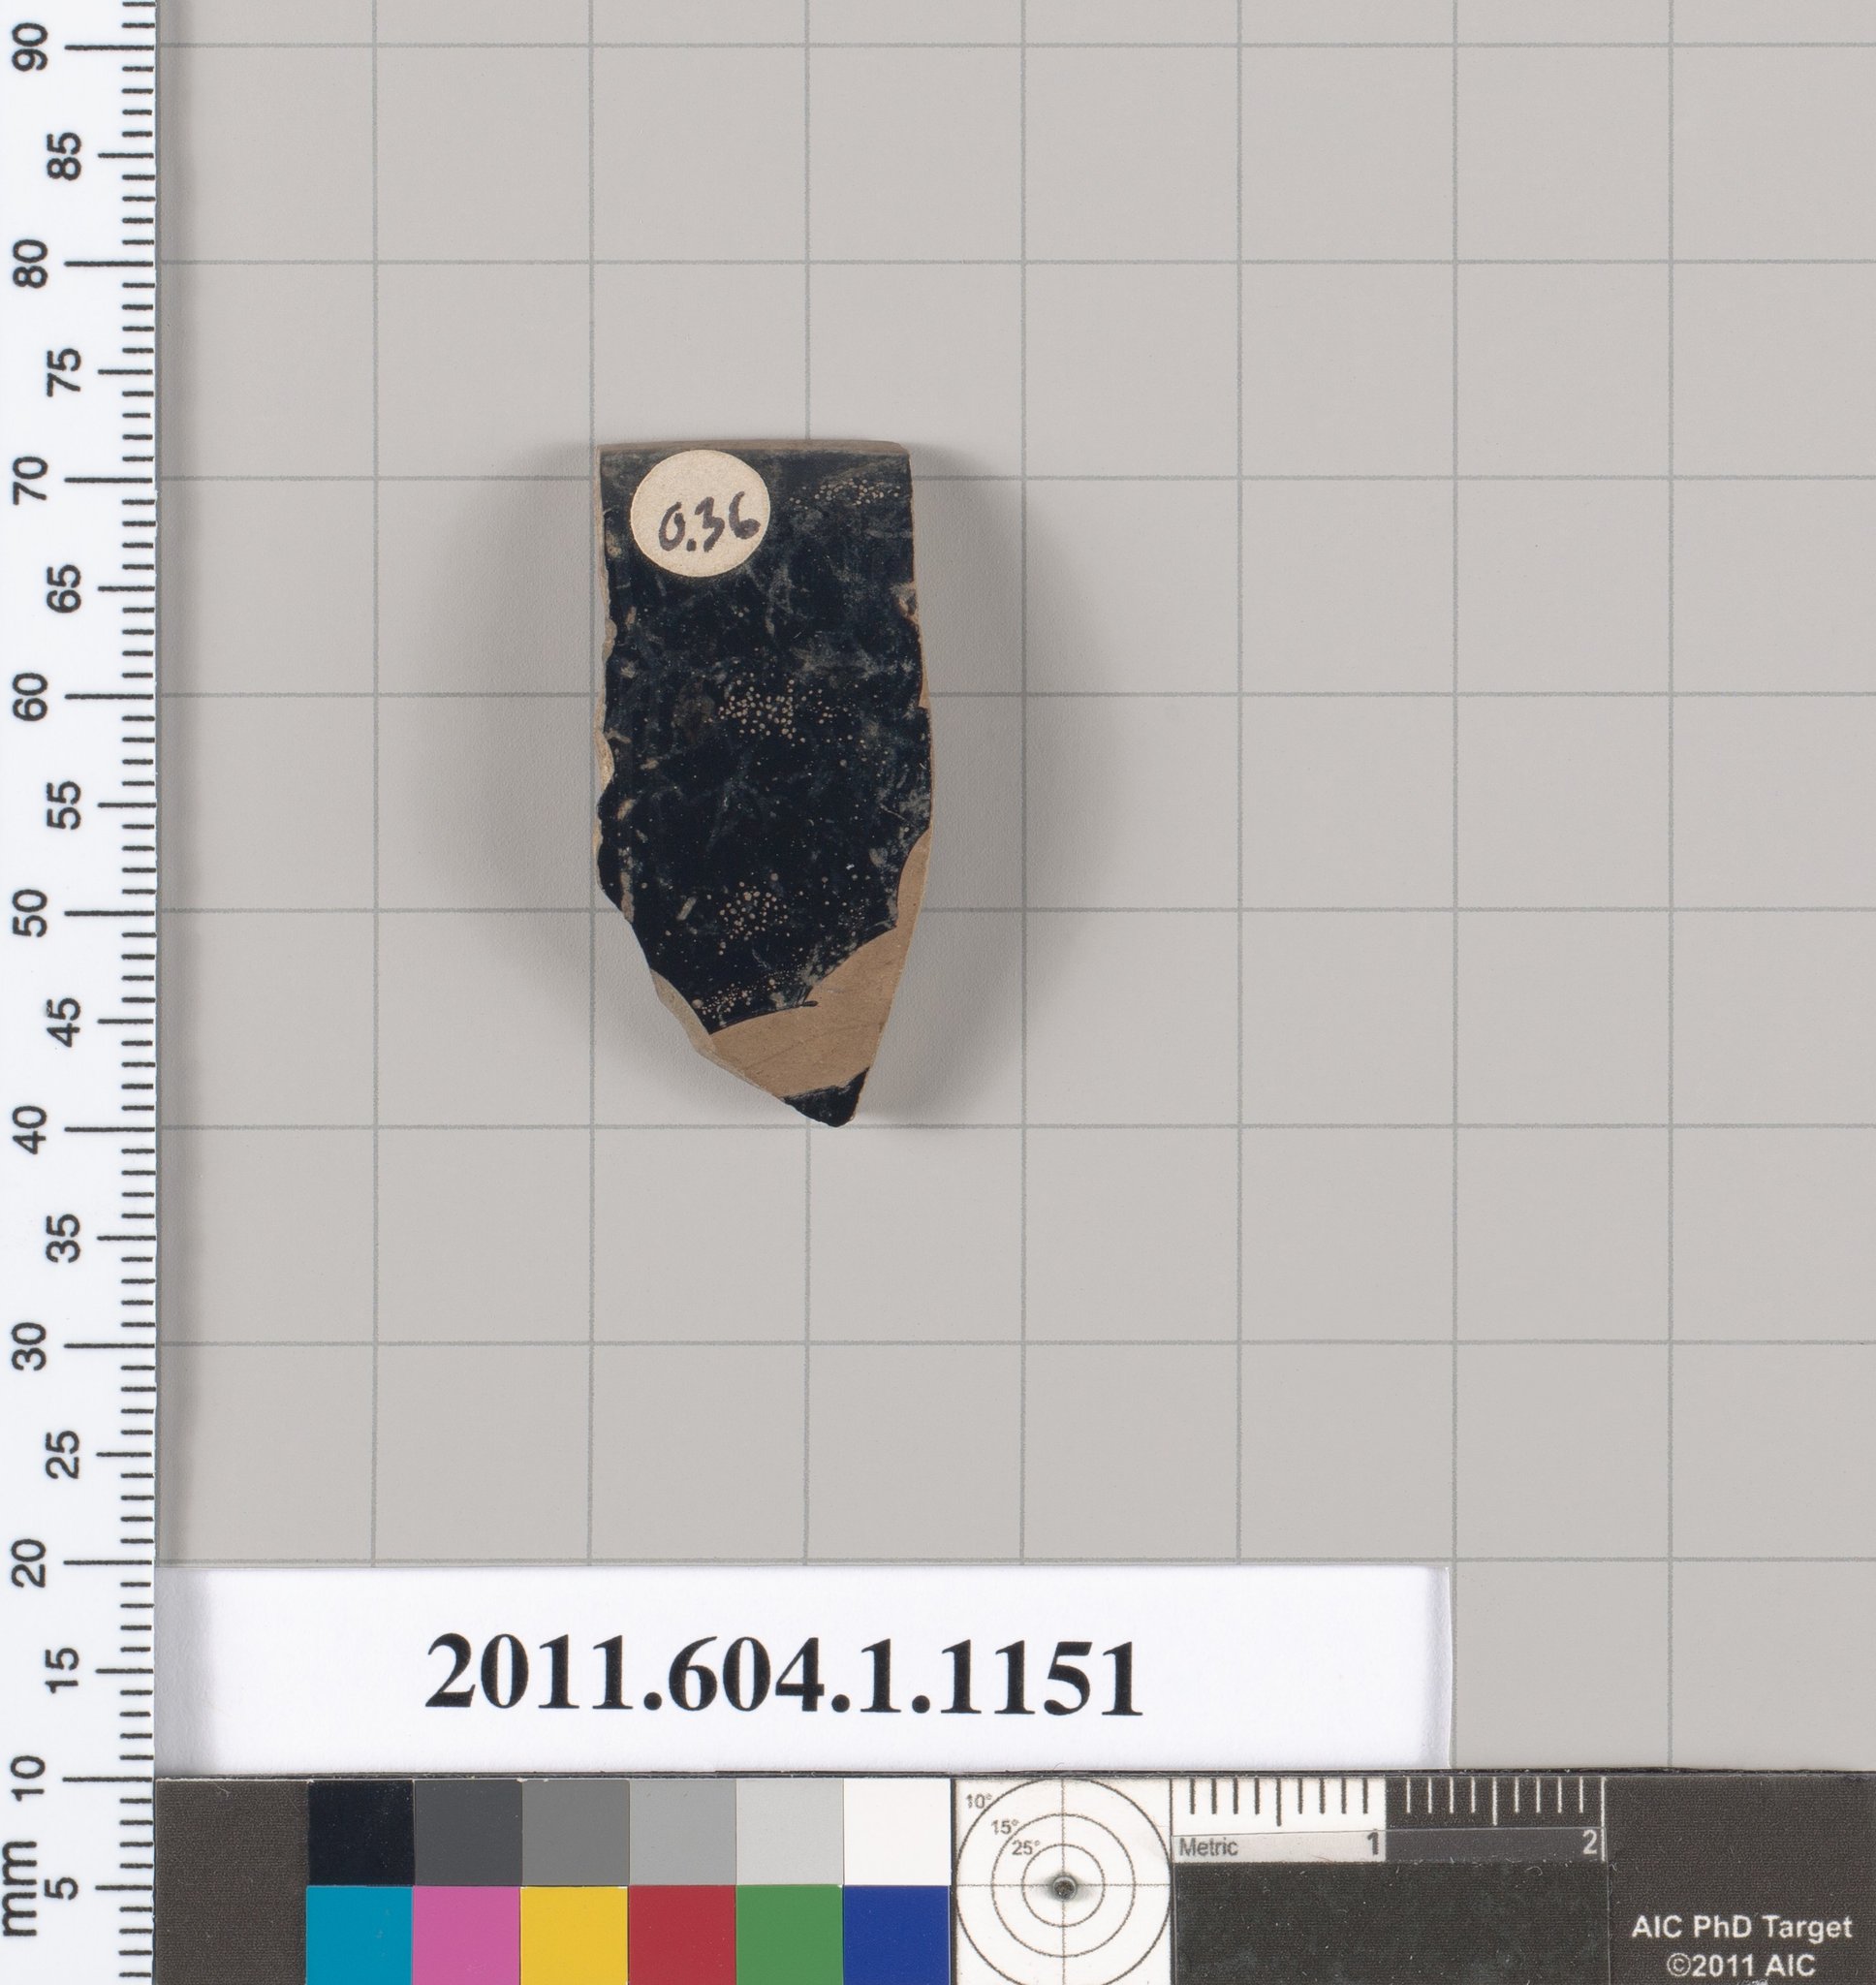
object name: kylix fragment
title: Terracotta rim fragment of a kylix (drinking cup)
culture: greek, attic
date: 475-451 BCE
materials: terracotta